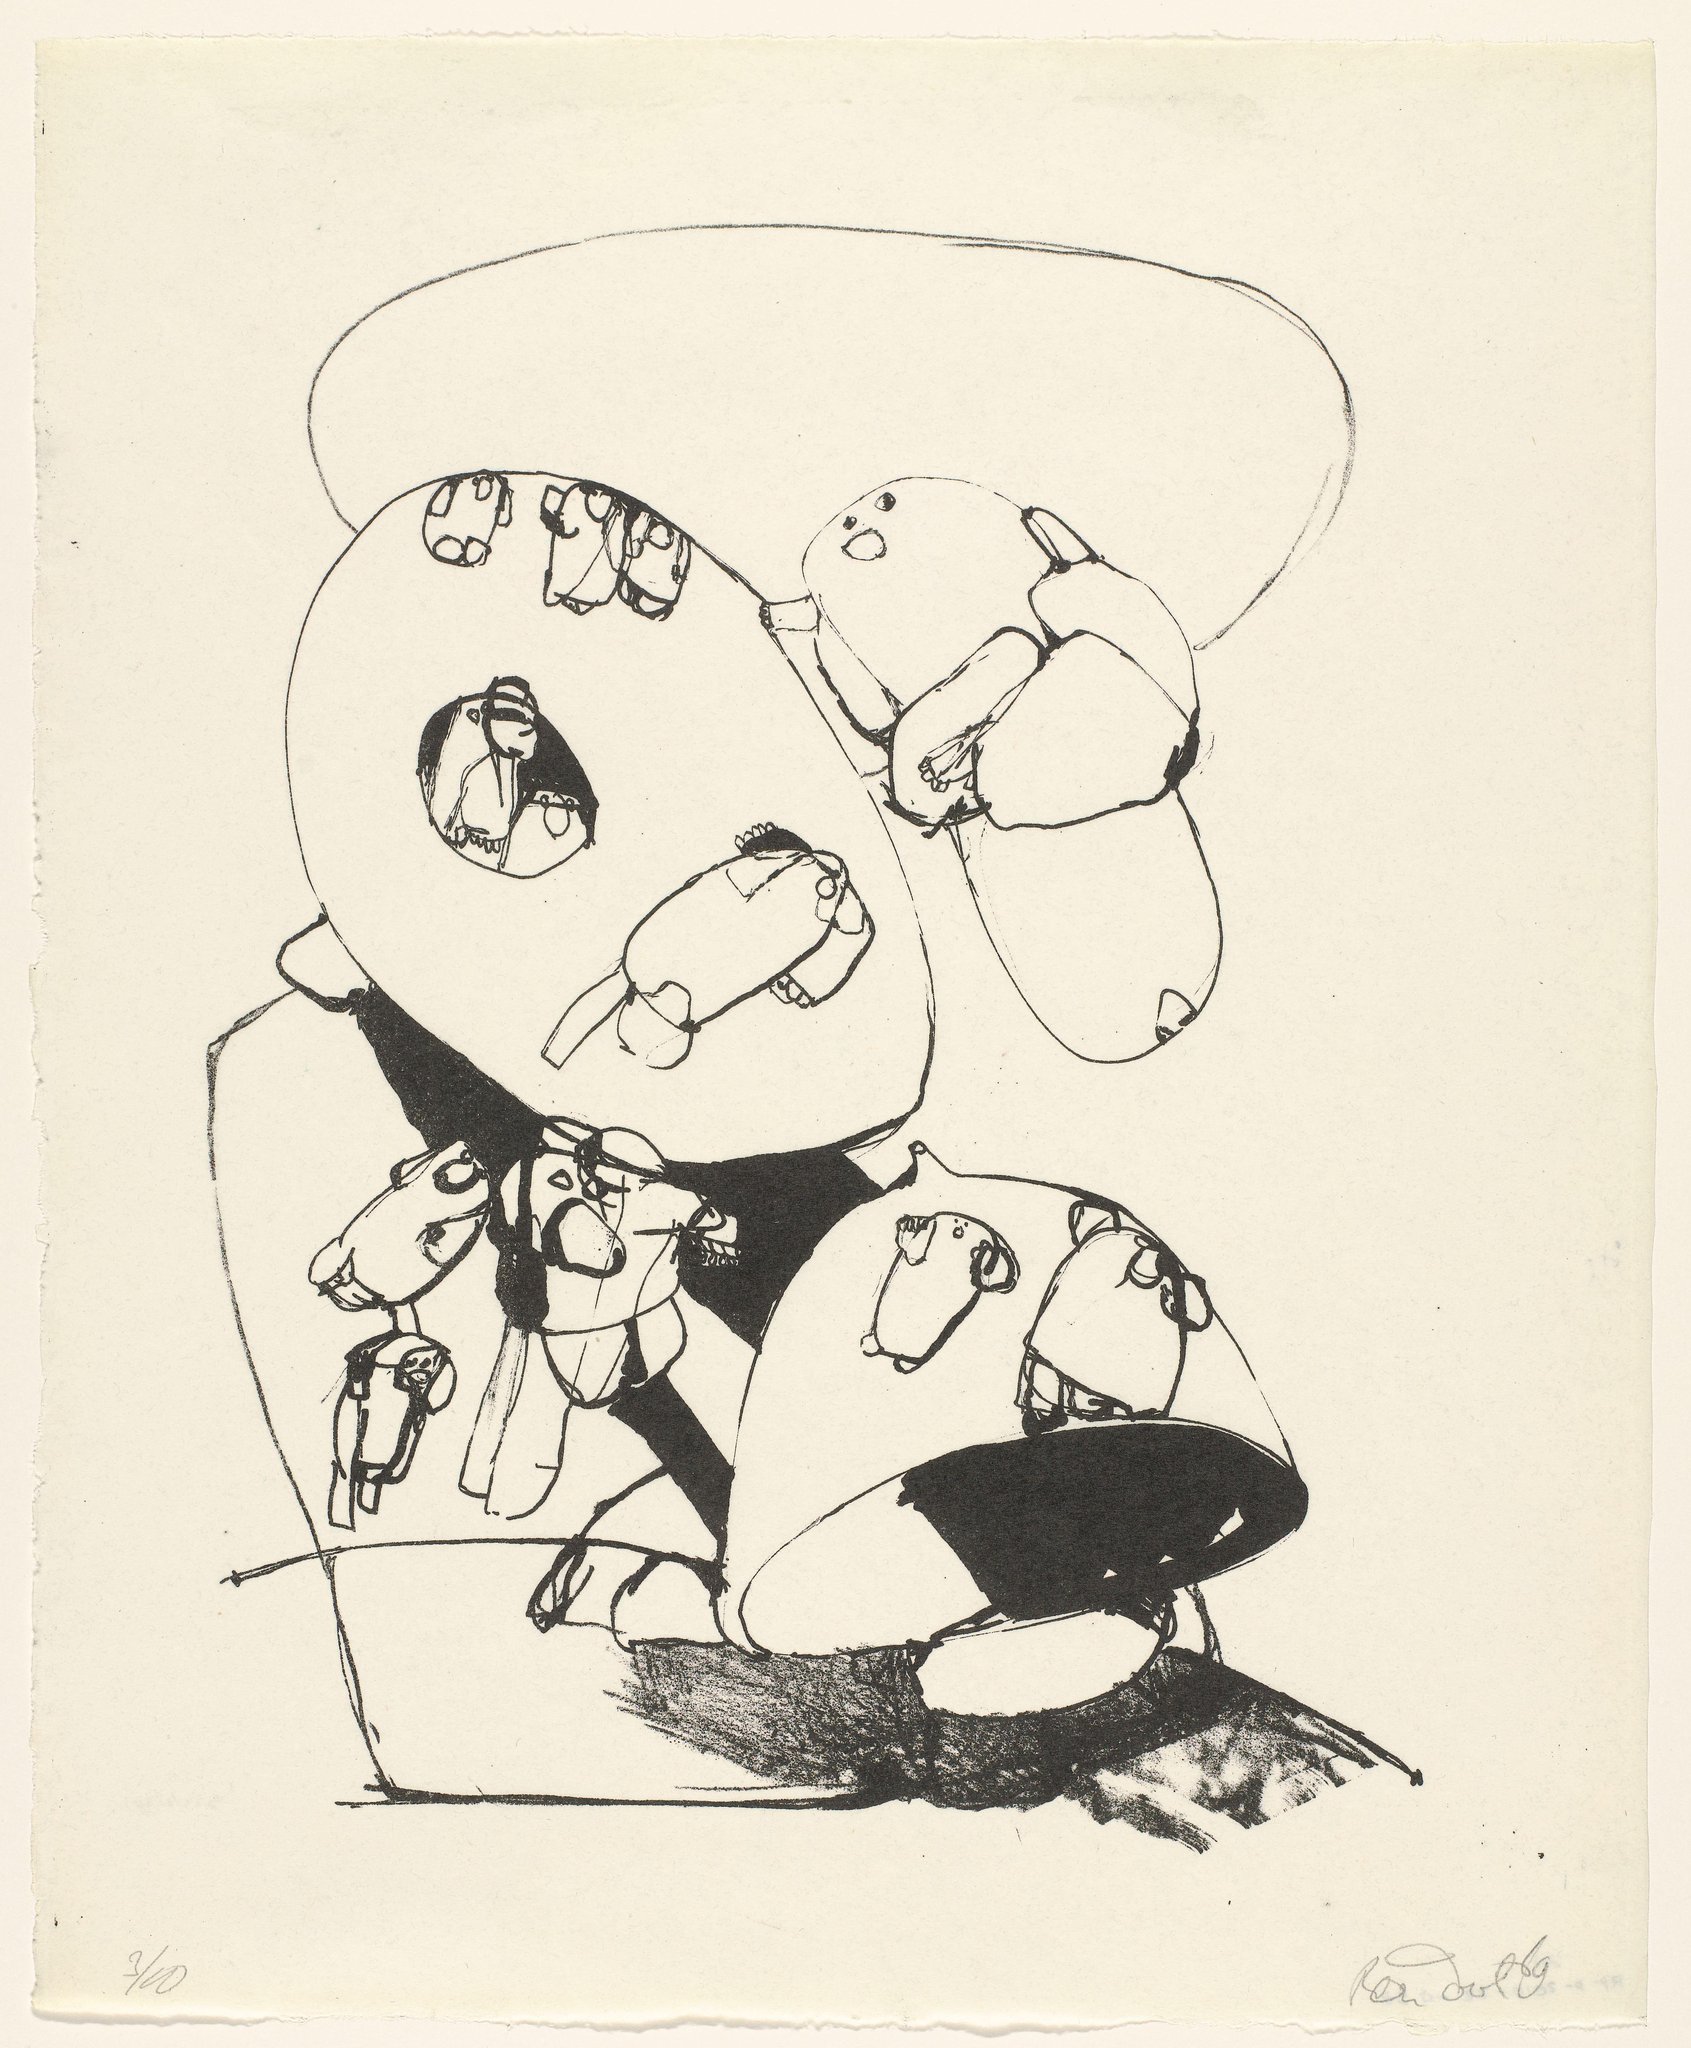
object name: print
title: Menselijke figuren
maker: rein dool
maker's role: draughtsman, painter, print maker, sculptor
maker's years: 1933-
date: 1969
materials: paper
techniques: lithograph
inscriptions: edition: ‘3/10’, signature and date: ‘Rein Dool 69’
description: Menselijke figuren met ellipsvormige rompen, onder een object in de vorm van een bel met aan de binnenkant een egale schaduw, op de achtergrond cirkels en ellipsen.